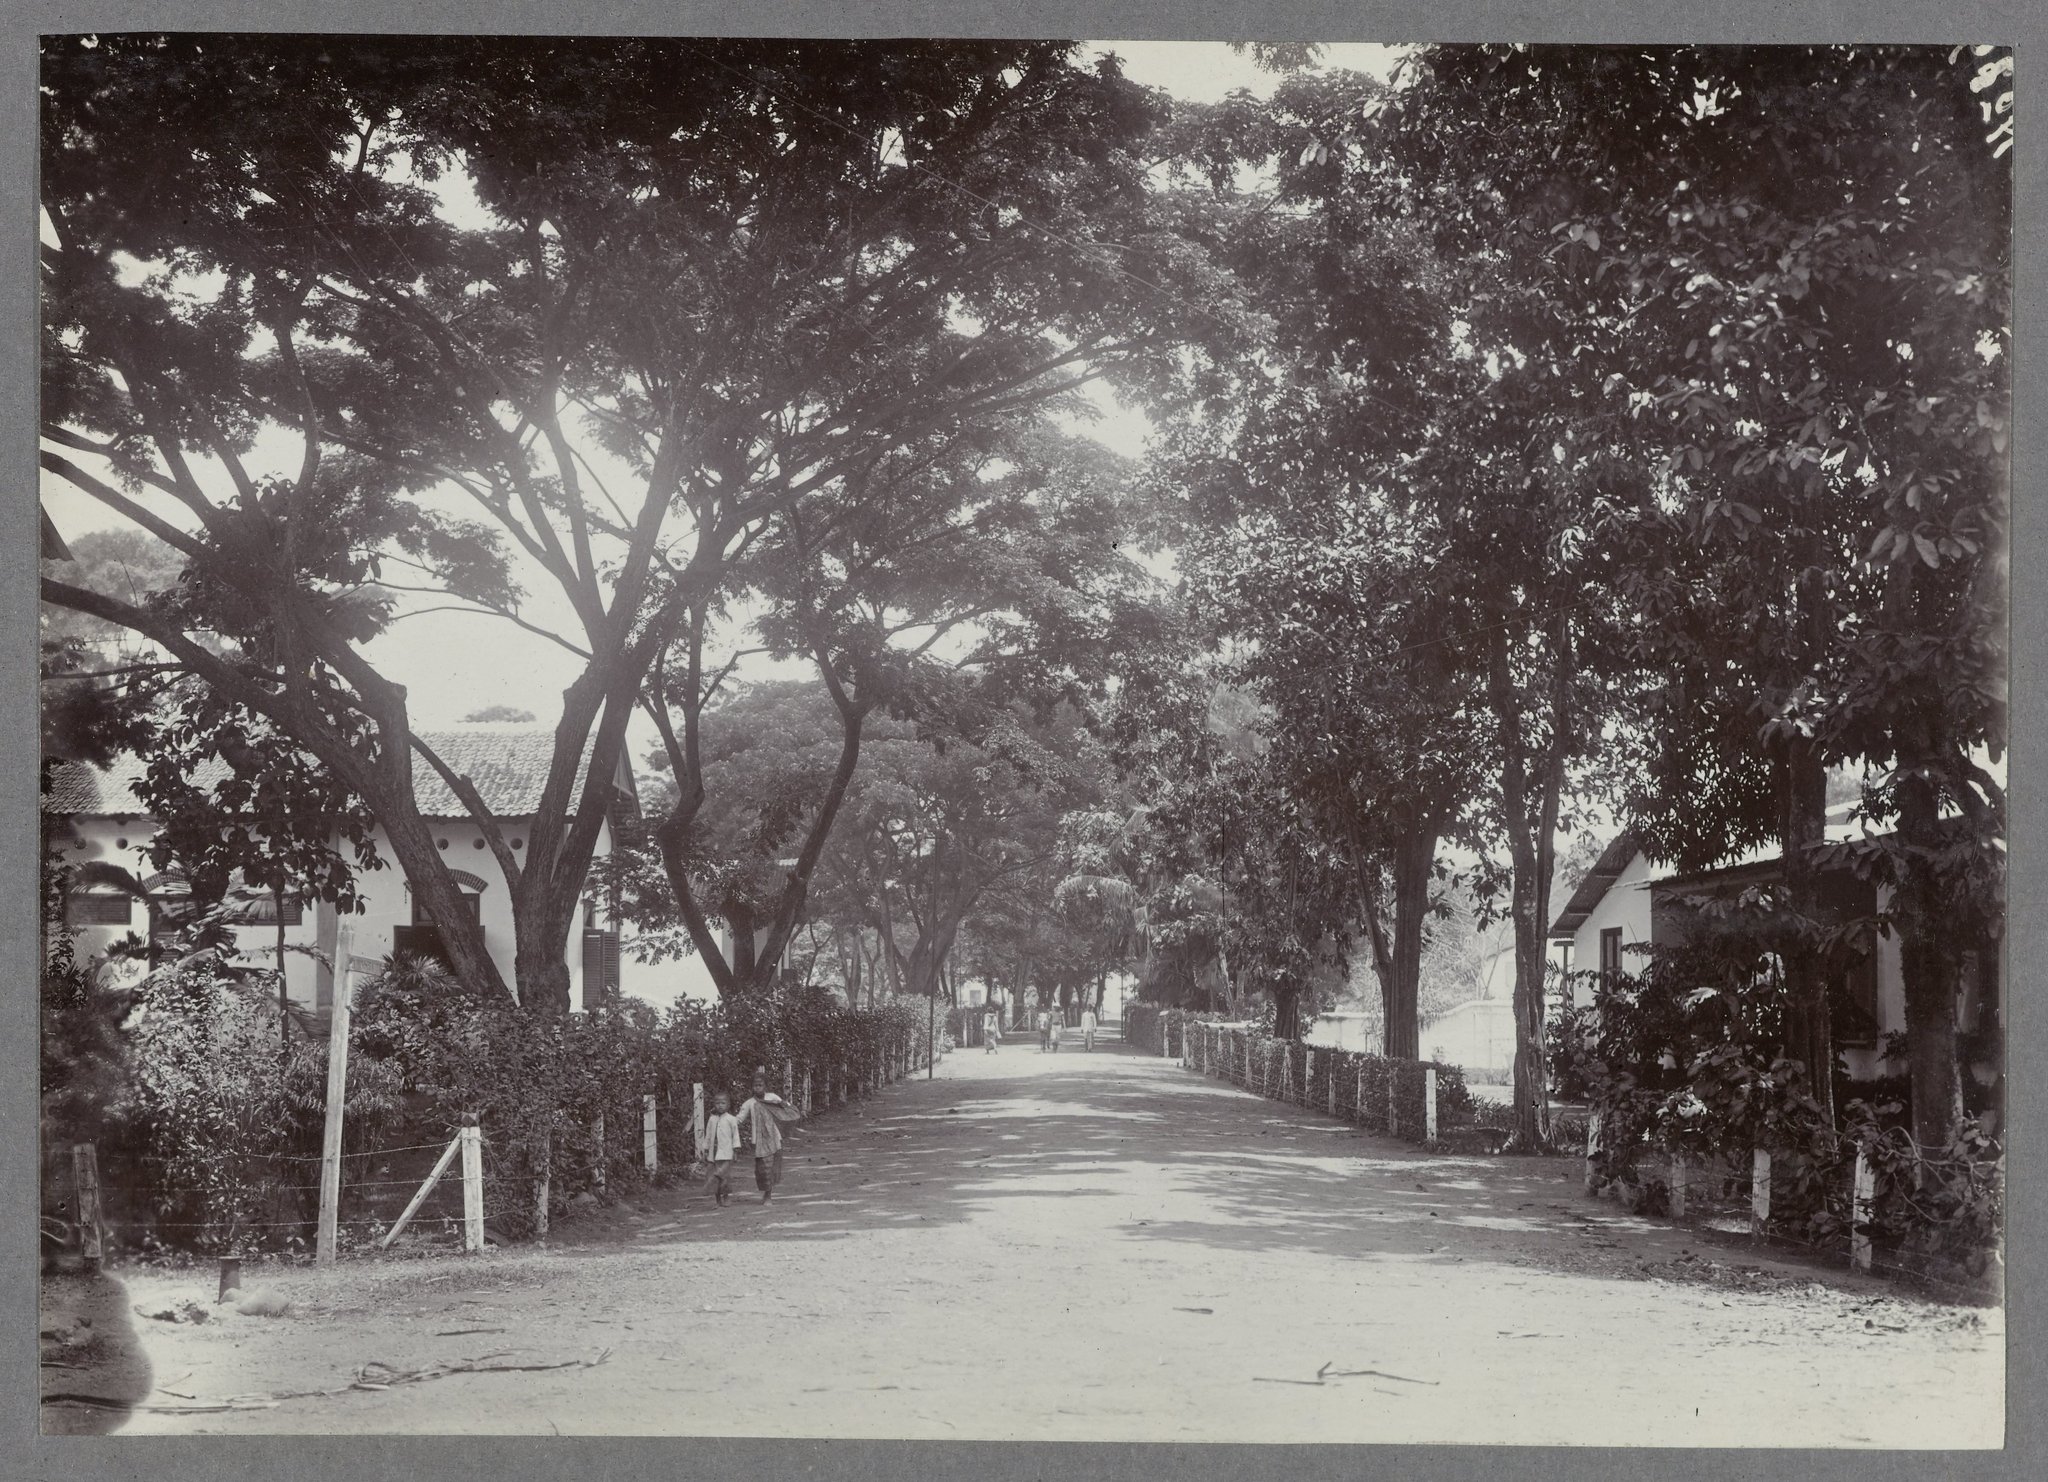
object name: photograph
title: Weg met huizen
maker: Anonymous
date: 1900-1919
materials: photographic support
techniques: collodion silver print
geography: comal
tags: colonial system, (non-fruit) products of plants or trees: sugarcane, exterior of industrial structures, factories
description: Een weg waarlangs bomen en huizen, waarschijnlijk behorend bij of in de omgeving van de suikerfabriek. Onderdeel van het fotoalbum van de Tjomal suikerfabriek in de periode ca. 1900-1919.